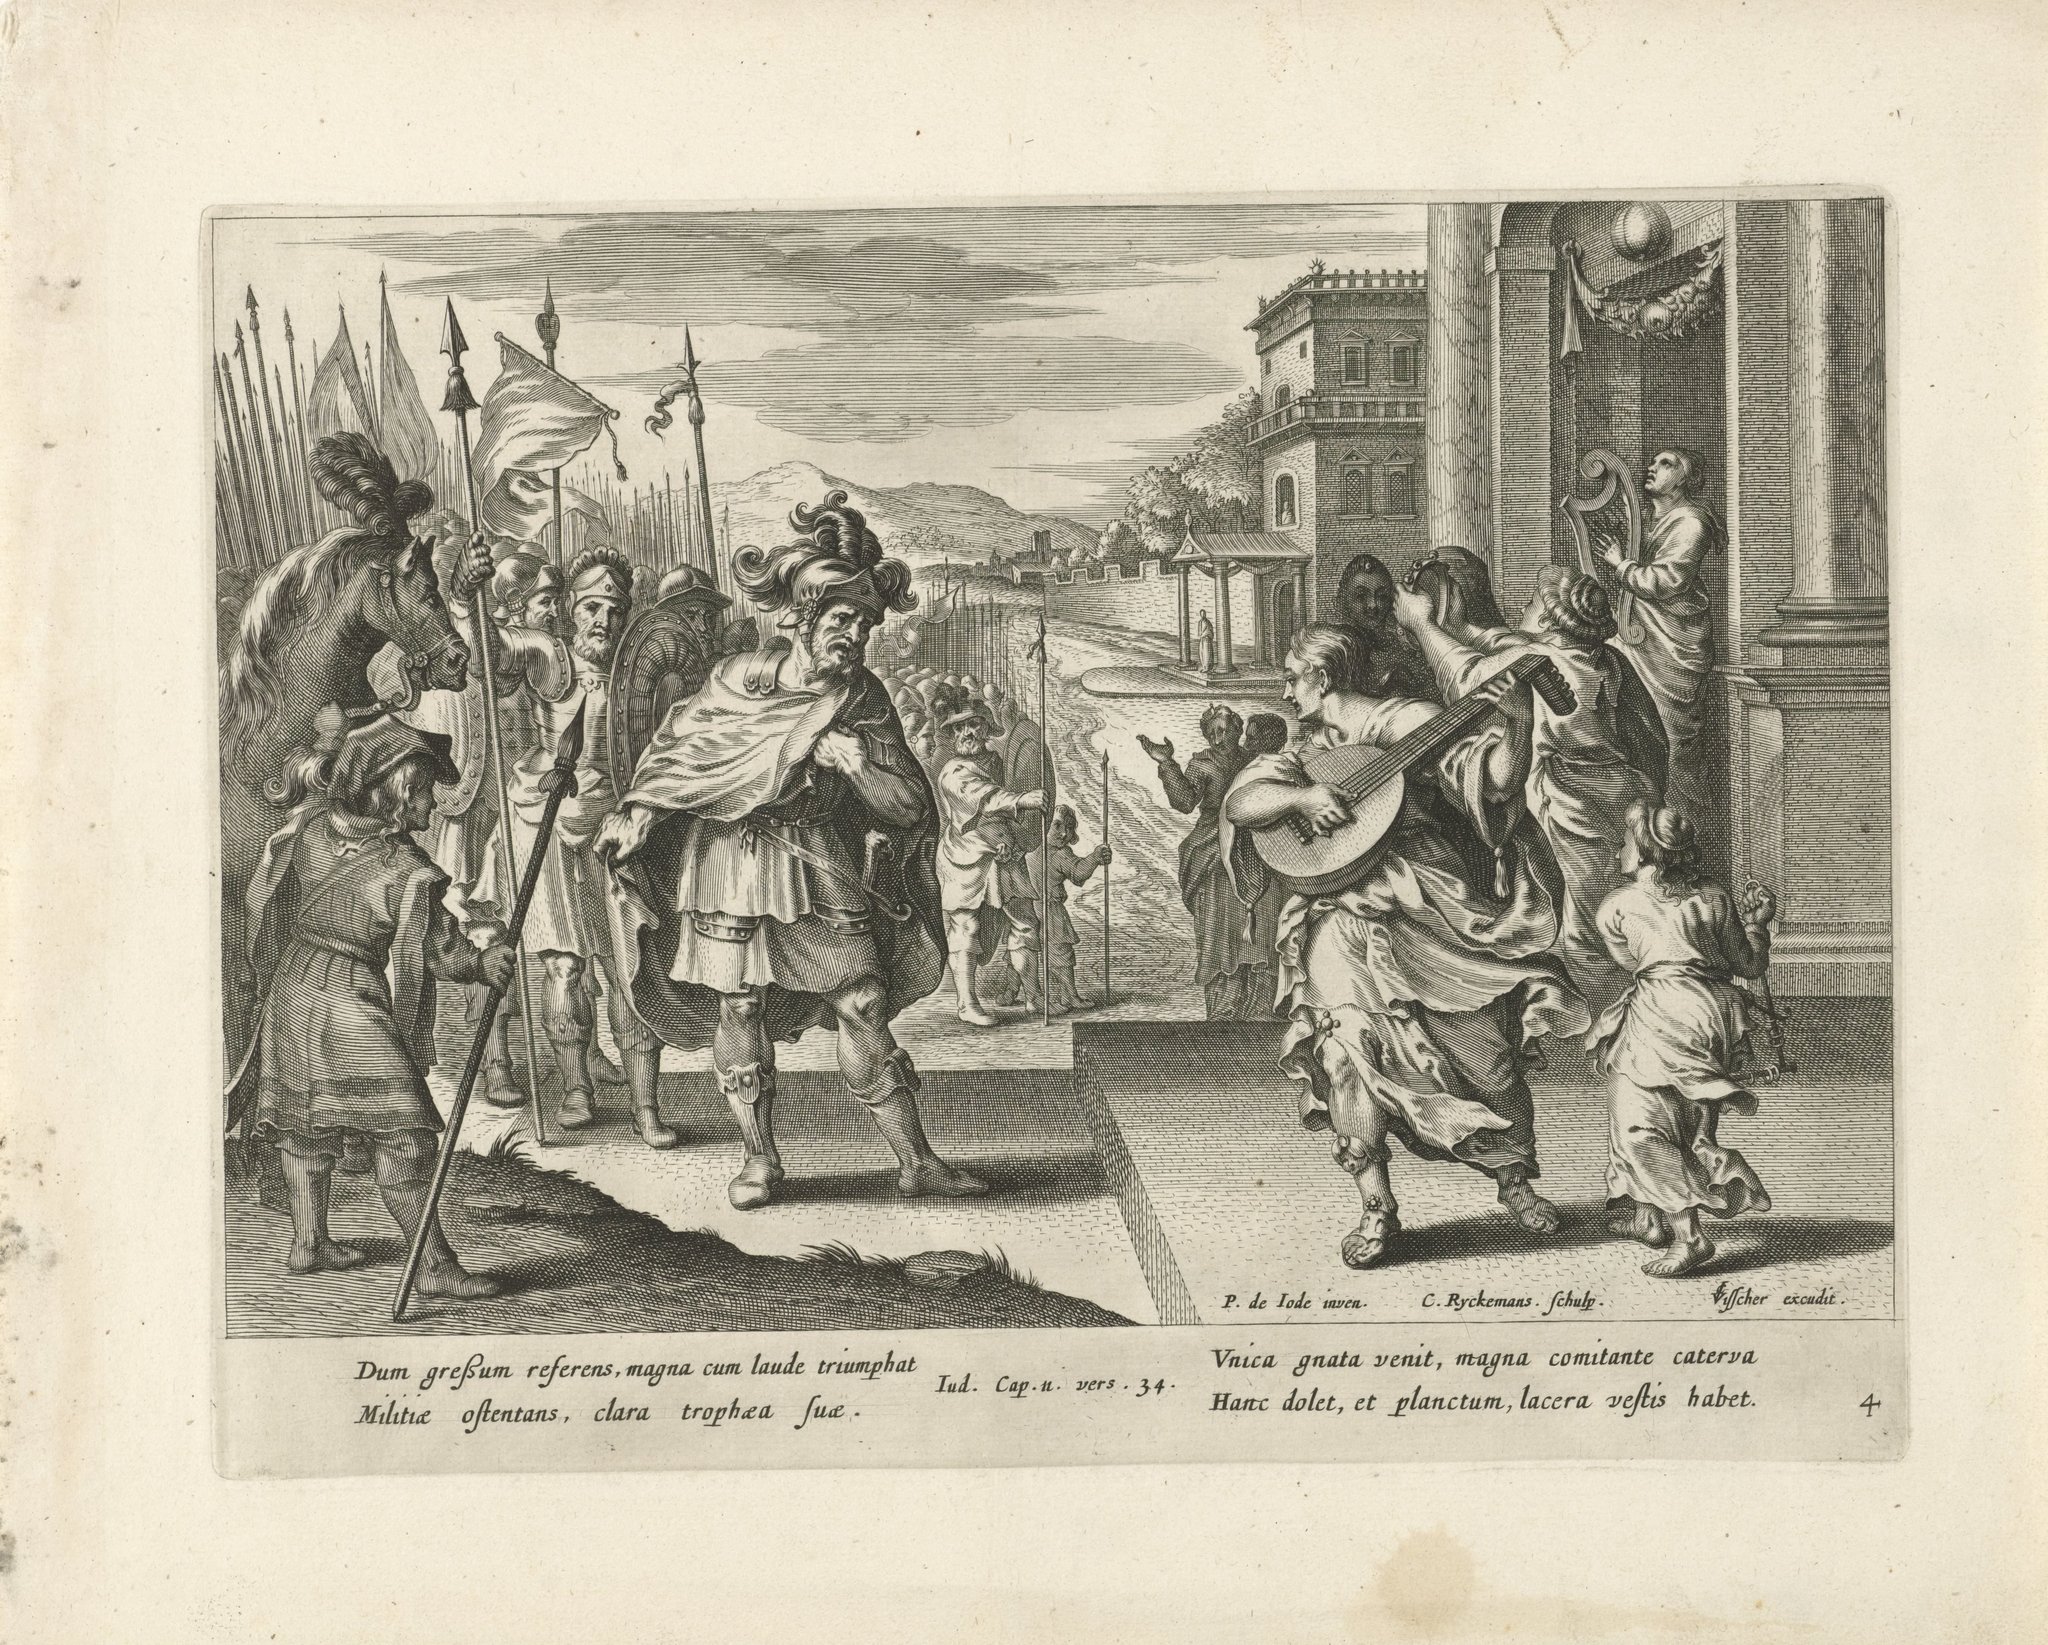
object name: print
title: Geschiedenis van Jefta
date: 1616-1643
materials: paper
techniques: engraving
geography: amsterdam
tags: jephthah's daughter dances with tambourines to meet her father on his return from the battle; jephthah rends his clothes in despair, other percussion instruments (with name)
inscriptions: collector's mark: Lugt 2228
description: Jefta komt terug na zijn overwinning op de Ammonieten en wordt feestelijk onthaald door zijn dochter en musicerende vrouwen (Ri. 11:34-36). Jefta staat op het punt zijn kleren in wanhoop te verscheuren, omdat hij God had beloofd het eerste dat hem uit zijn huis tegemoet zou treden te offeren, dit blijkt zijn dochter te zijn.